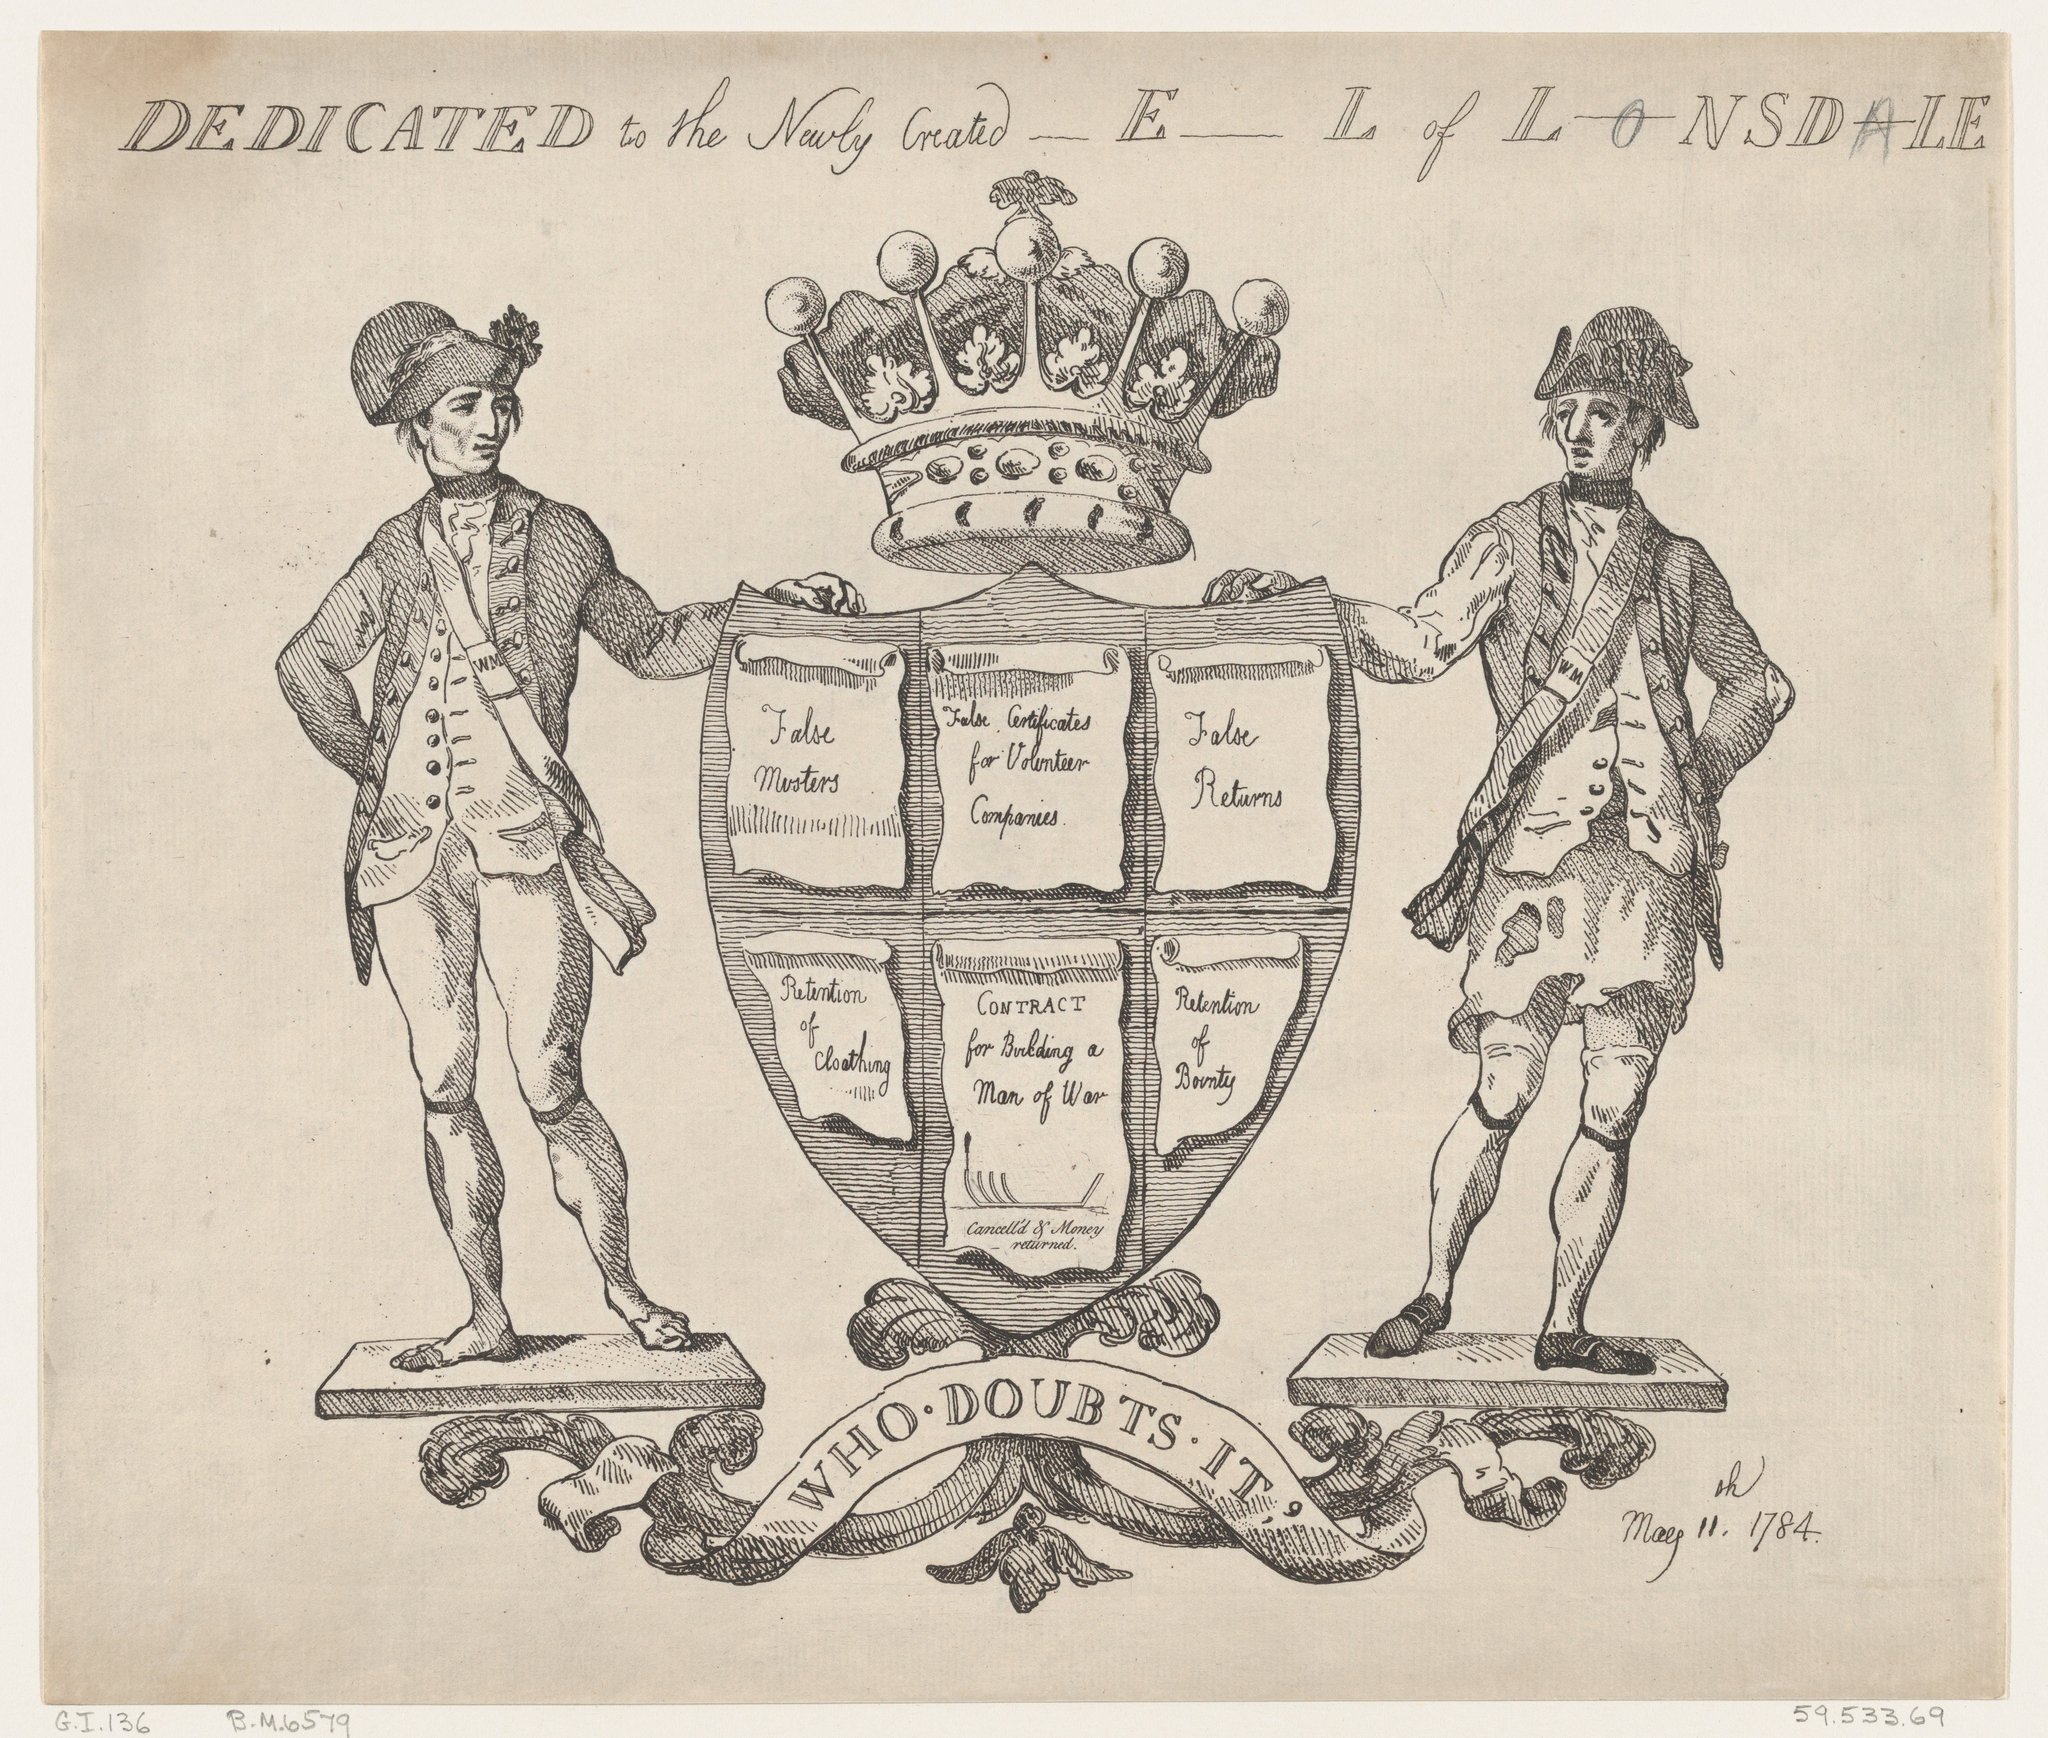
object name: print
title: Dedicated to the Newly Created E-l of L-nsd-le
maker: thomas rowlandson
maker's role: artist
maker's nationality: british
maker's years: 1757-1827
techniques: etching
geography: london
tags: men,coat of arms